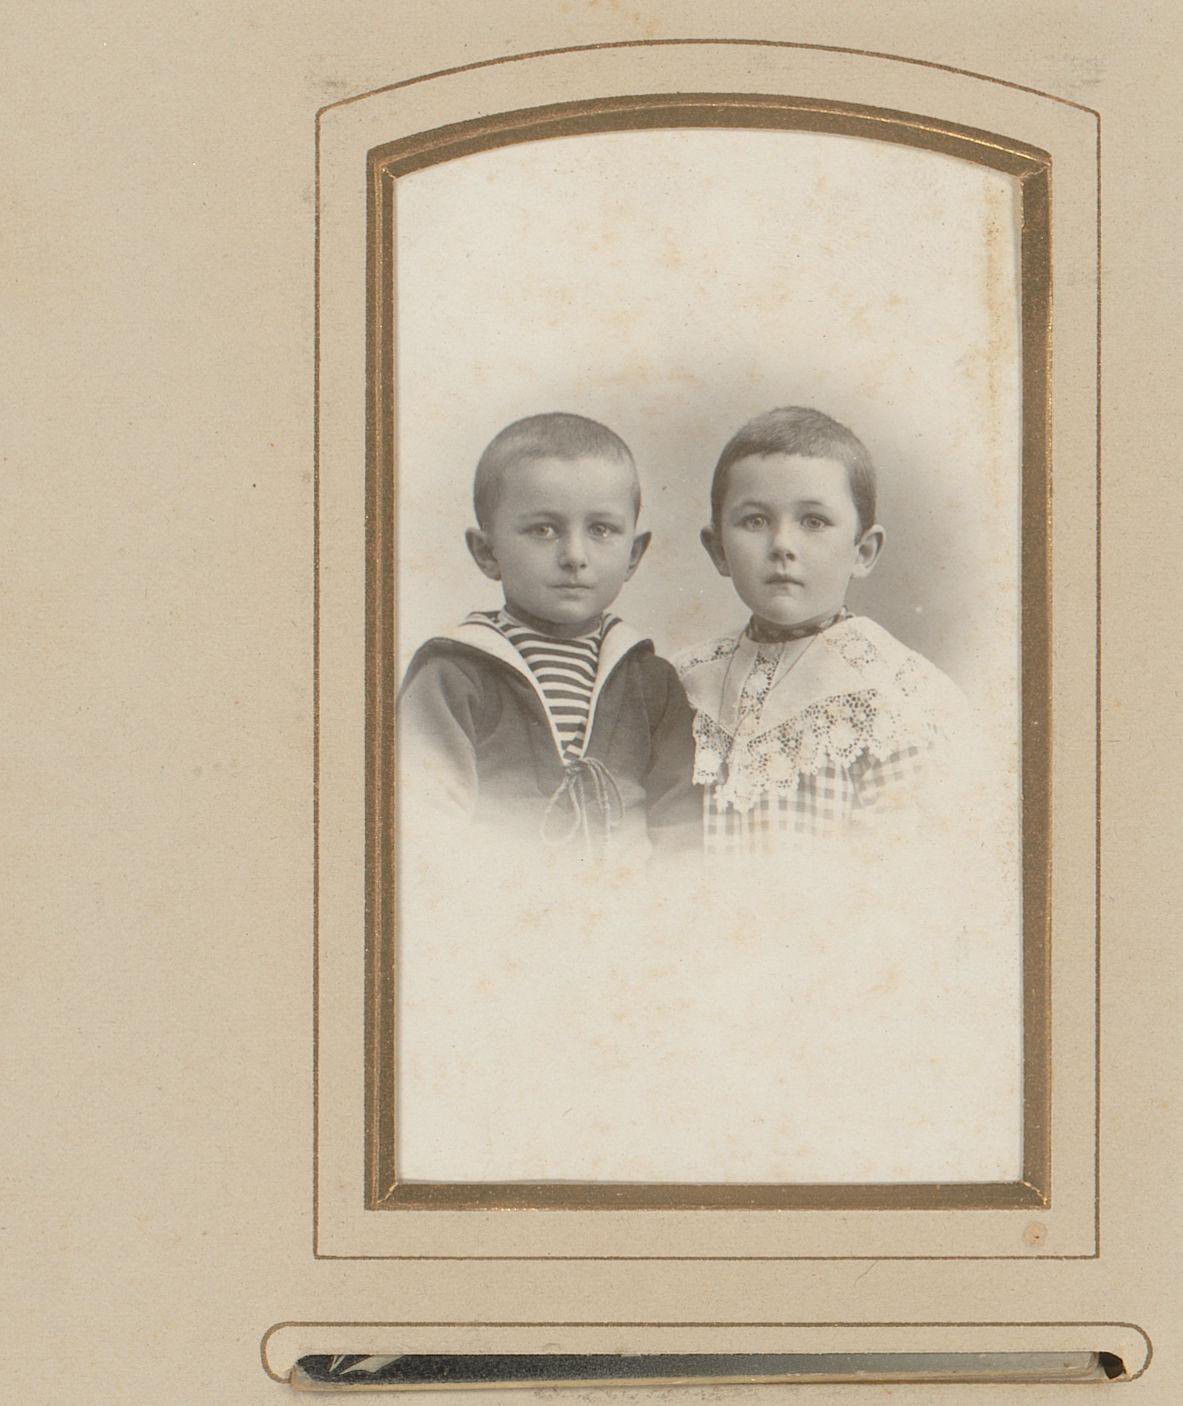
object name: photograph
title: Portret van een jongen en een meisje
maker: victoire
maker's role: fotograaf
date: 1895-1920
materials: cardboard, photographic support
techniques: matte daylight collodion silver print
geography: lyon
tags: historical persons - bb - woman, historical persons, toddler (male), toddler (female)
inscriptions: inscription: ‘MAISON FONDÉE en 1850/ 7 Médailles d'Or/ Membre du Jury Hors-Concours/ Victoire/ 22/ Rue Paul Chenavard/ EX-RUE ST PIERRE/ Lyon/ Hôtel-Privé/ au 1er Etage/ Téléphone/ 1.80’